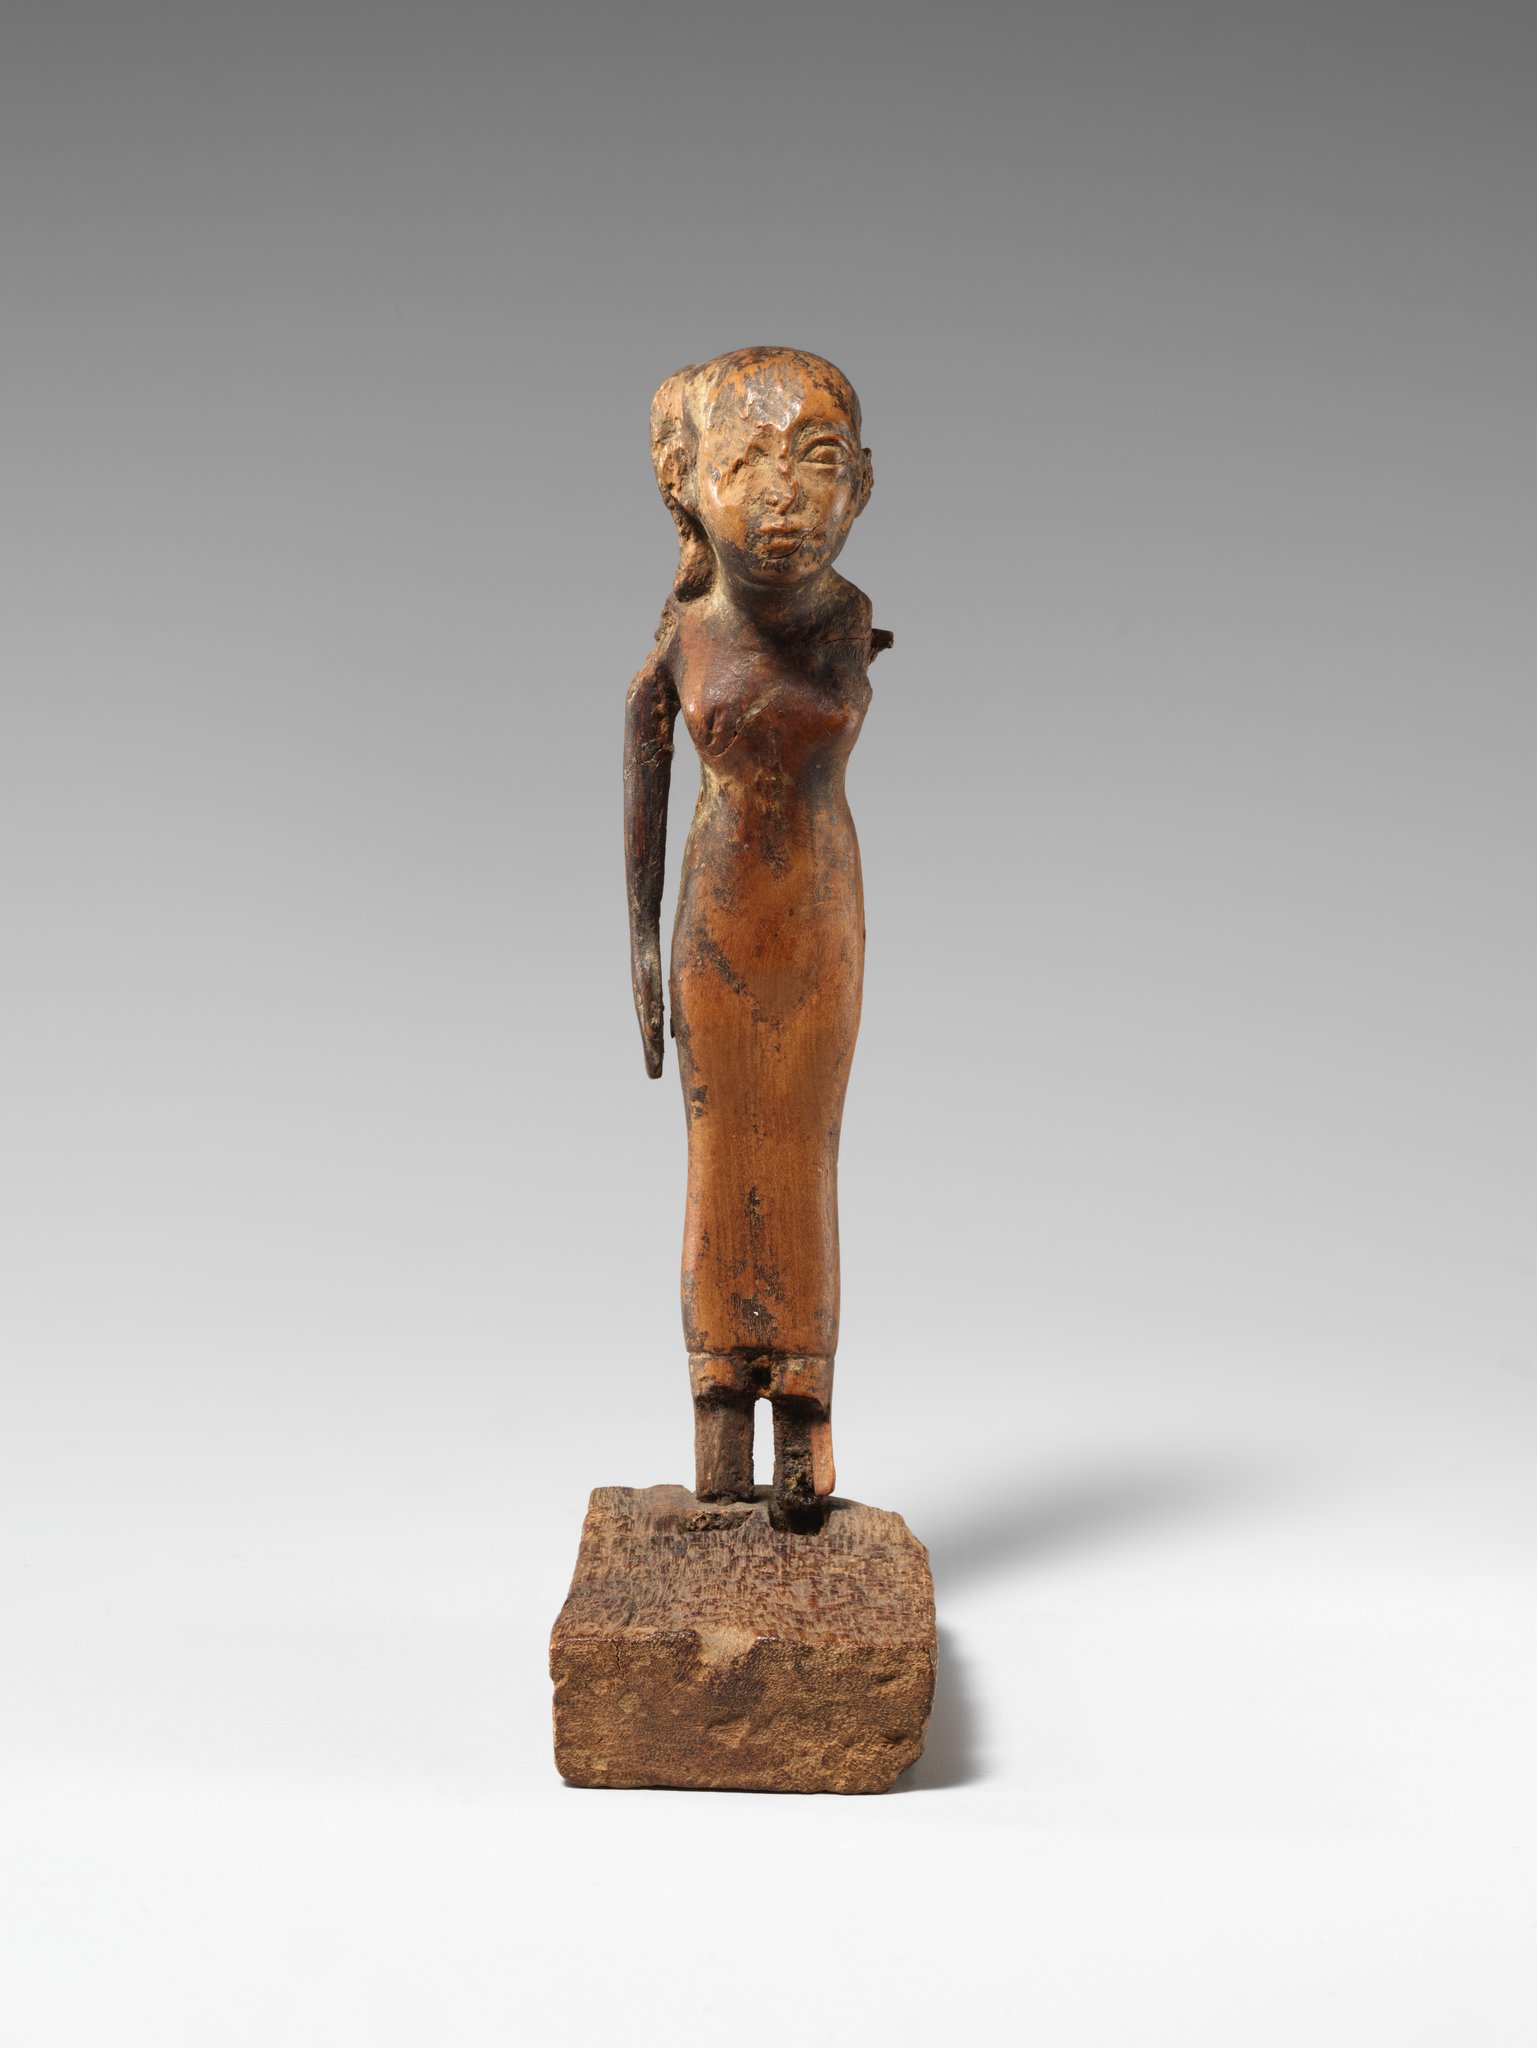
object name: statuette of reniseneb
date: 1850-1650 BCE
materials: paint, wood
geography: egypt